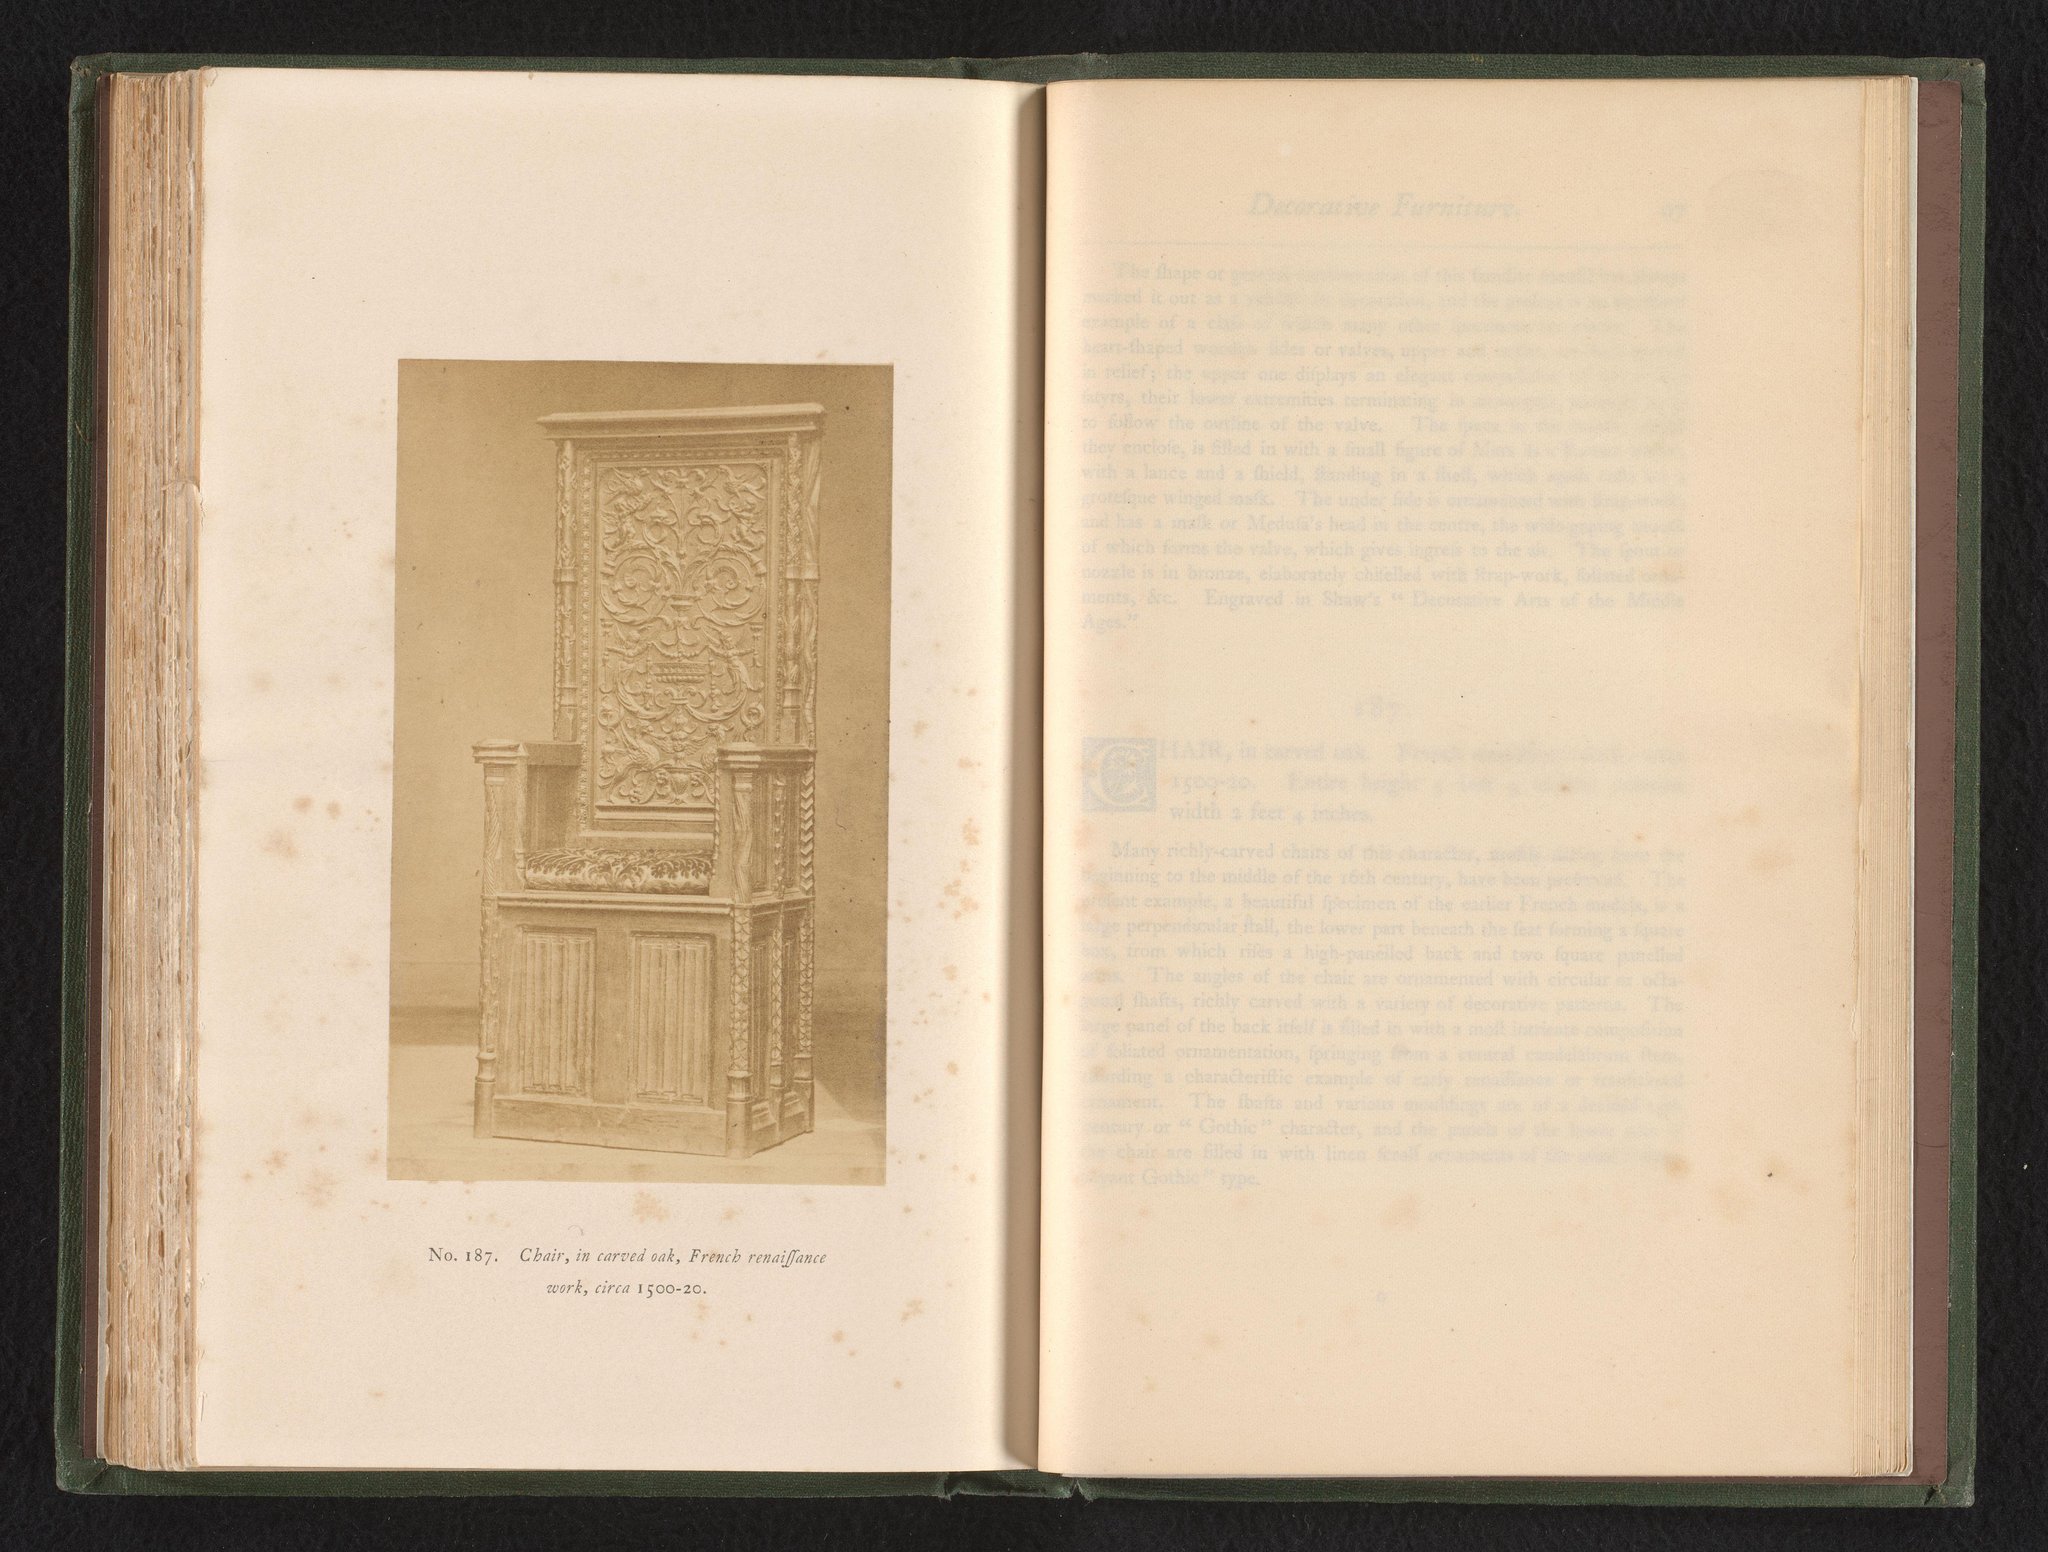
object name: page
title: Chair, in carved oak, French renaissance work, circa 1500- 1520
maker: Anonymous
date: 1851-1861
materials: paper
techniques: albumen print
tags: wood carver, chair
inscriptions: number: ‘No. 187.’